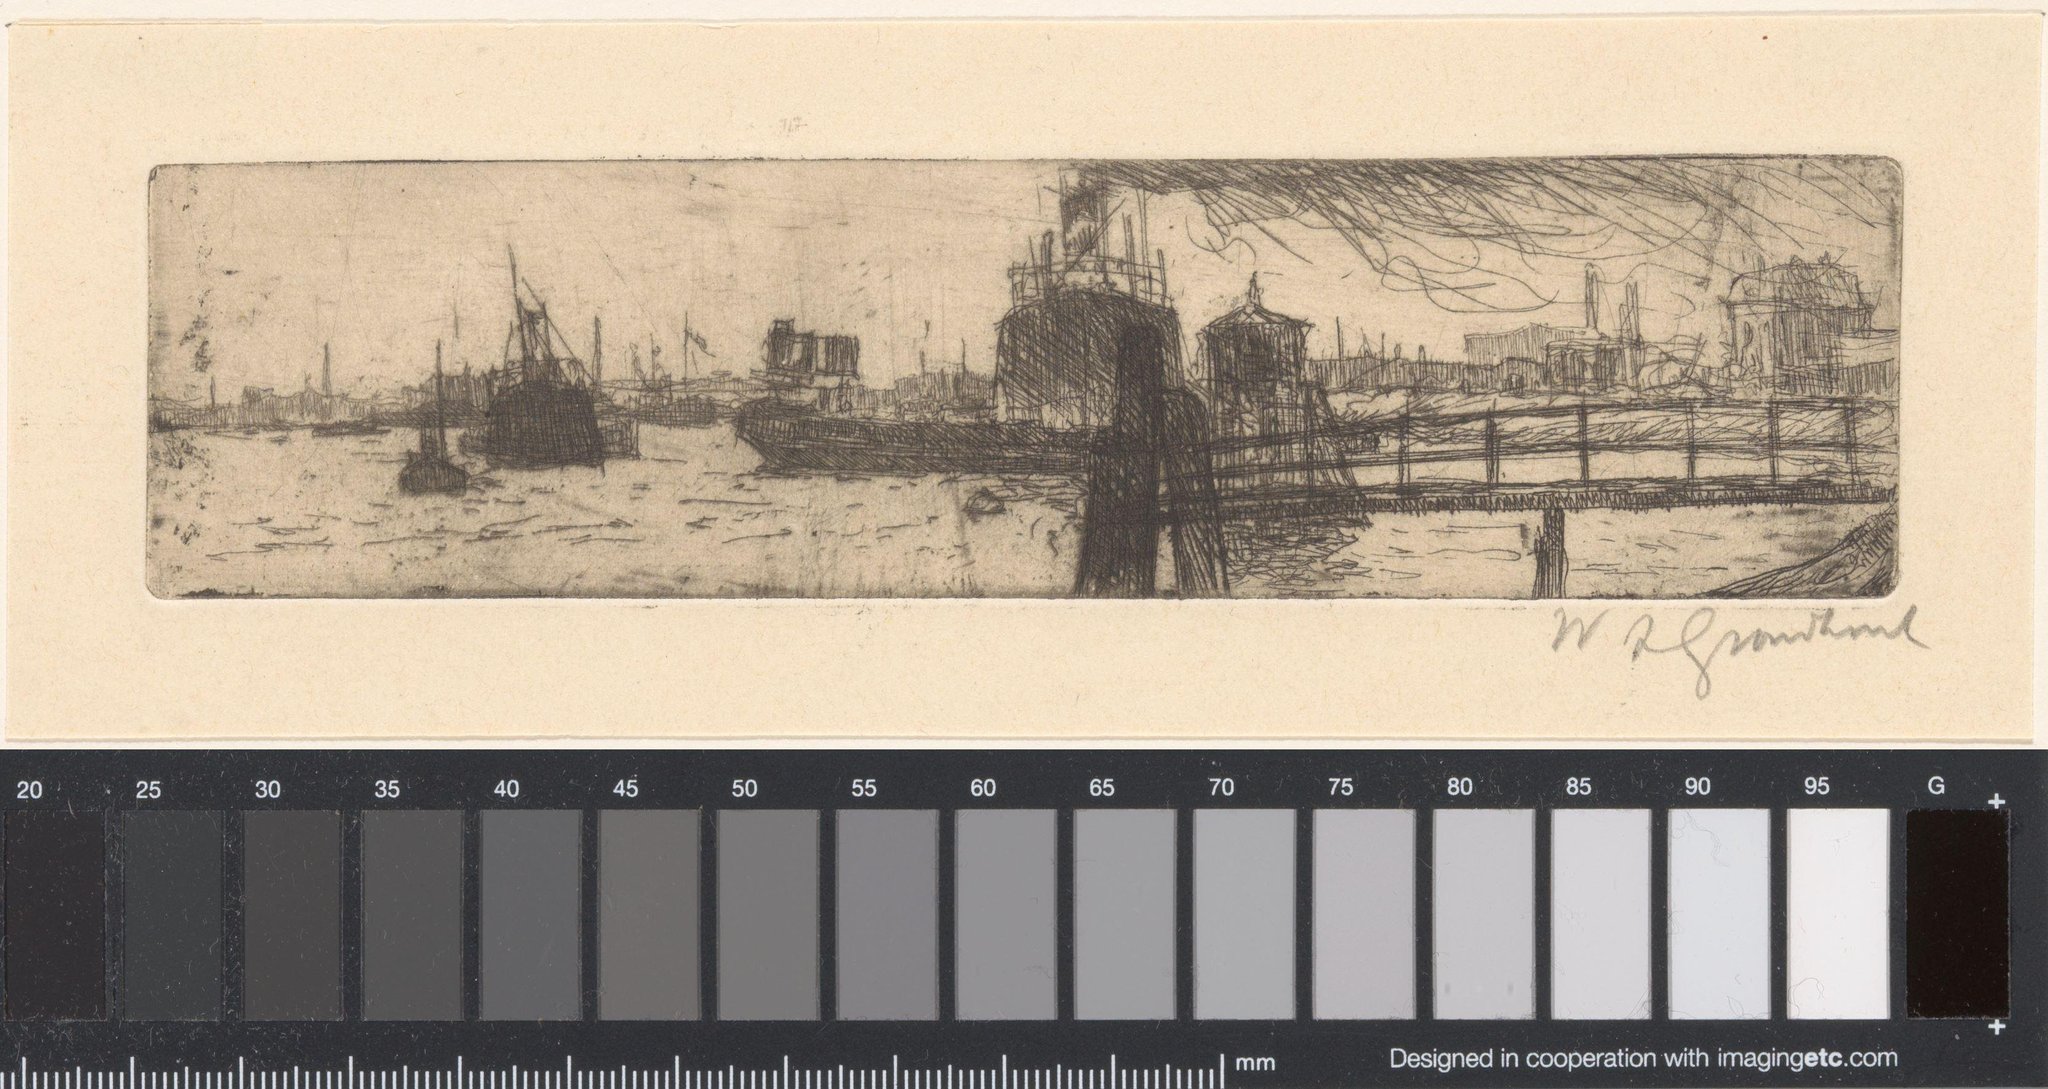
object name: print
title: De steiger aan de Maas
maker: willem adrianus grondhout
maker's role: draughtsman, painter, print maker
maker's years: 1878-1934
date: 1888-1931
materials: paper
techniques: etching, intaglio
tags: canals, waters (in city), pier, quay, wharf, rotterdam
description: Op de achtergrond schepen op de Maas bij Rotterdam.